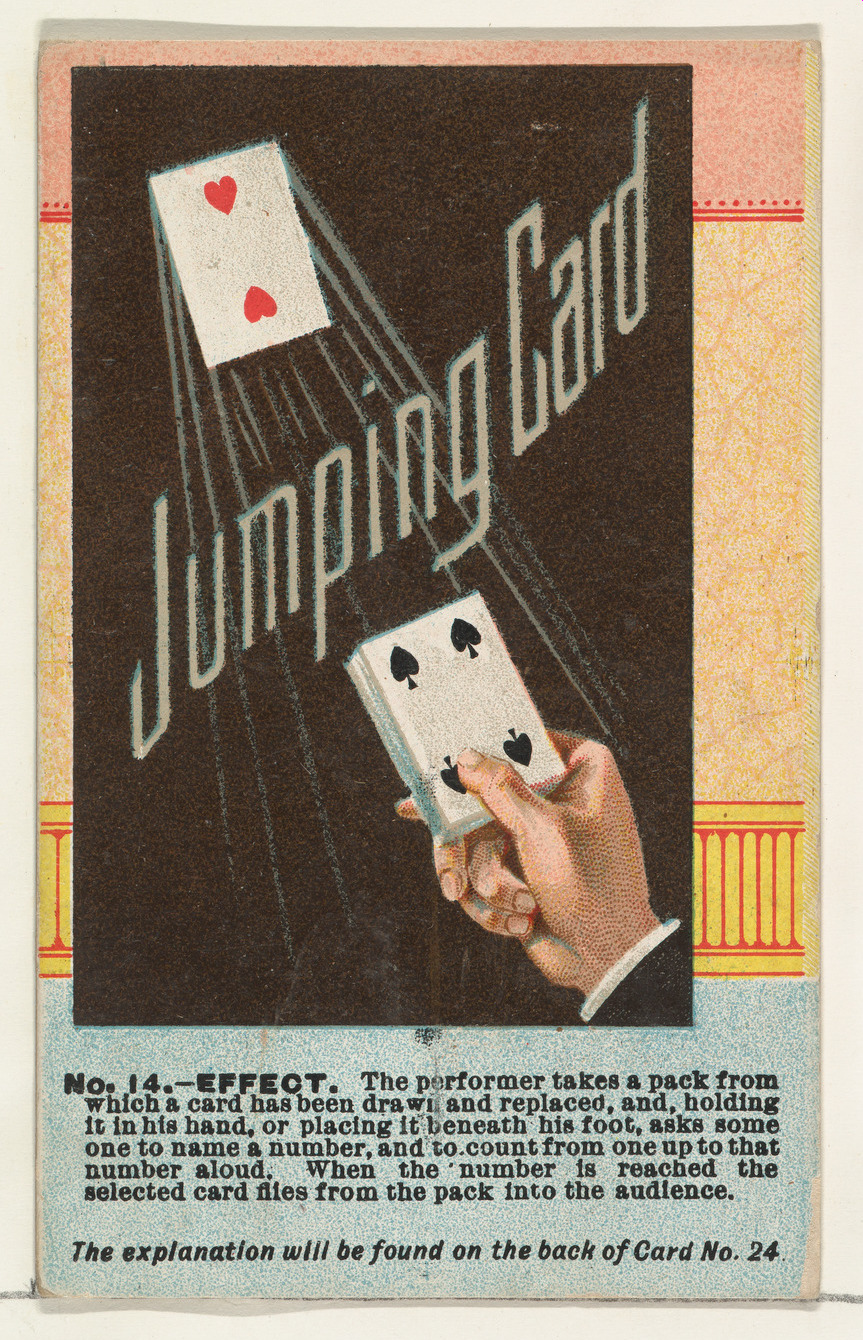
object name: print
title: Number 14, Jumping Card, from the Tricks with Cards series (N138) issued by W. Duke, Sons & Co. to promote Honest Long Cut Tobacco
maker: w. duke, sons & co.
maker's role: publisher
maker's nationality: american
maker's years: 1870-1920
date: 1887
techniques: color lithograph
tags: hands,magic,playing cards